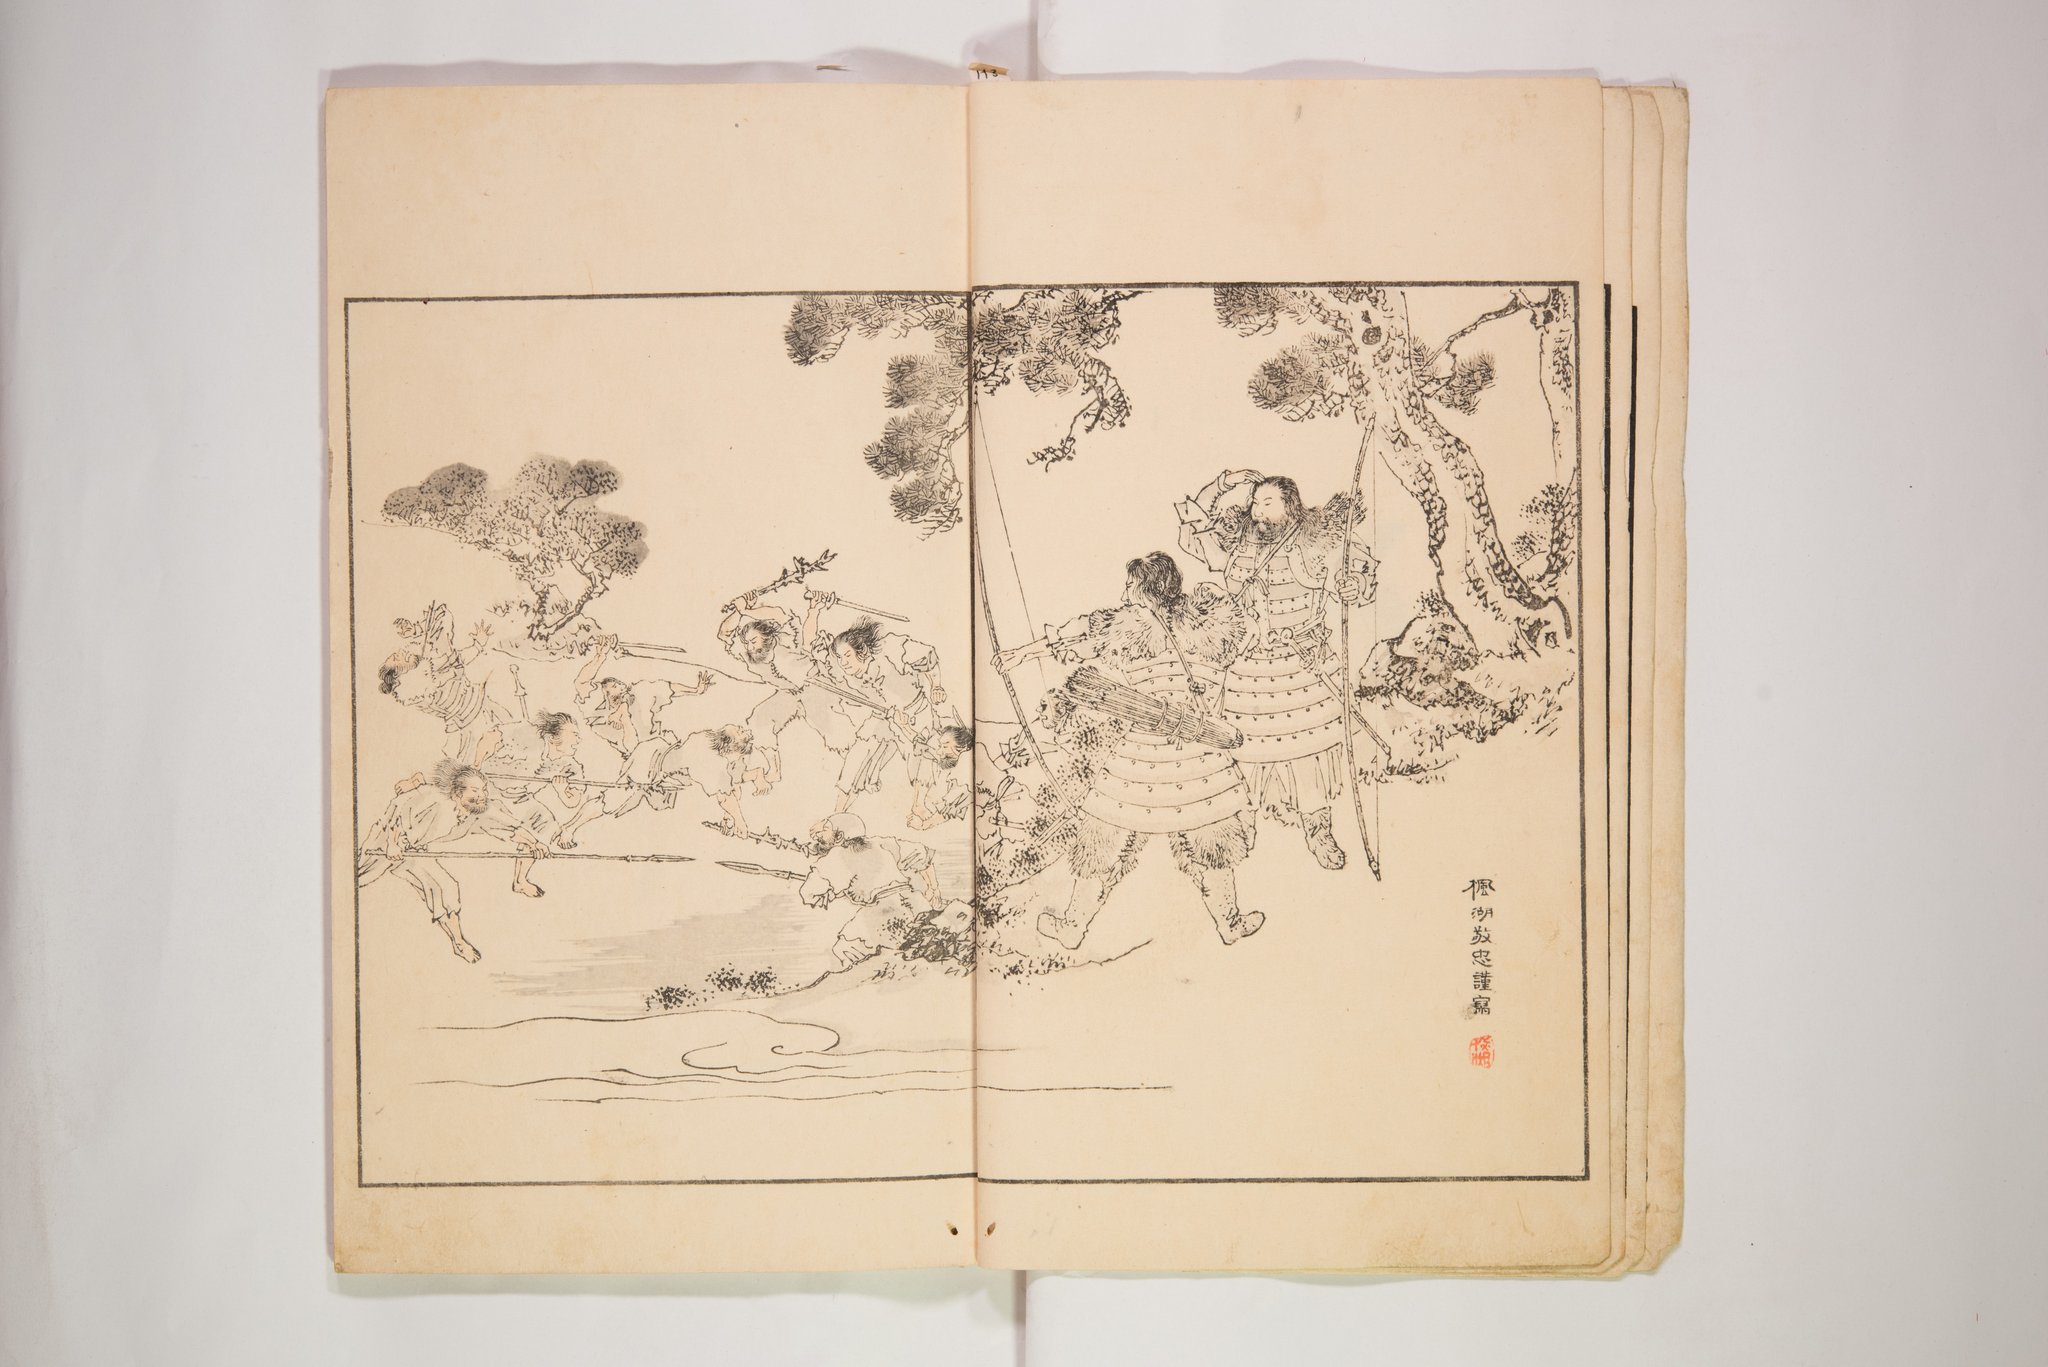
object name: illustrated book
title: Illustrated Journal of Japanese History no. 1-10 (Nihon Rekishi Gaho) 日本歴史画報（にほんれきしがほう）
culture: japanese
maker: matsumoto fūko 松本楓湖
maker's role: artist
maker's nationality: japanese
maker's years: 1840-1923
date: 1892-1893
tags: battles,trees